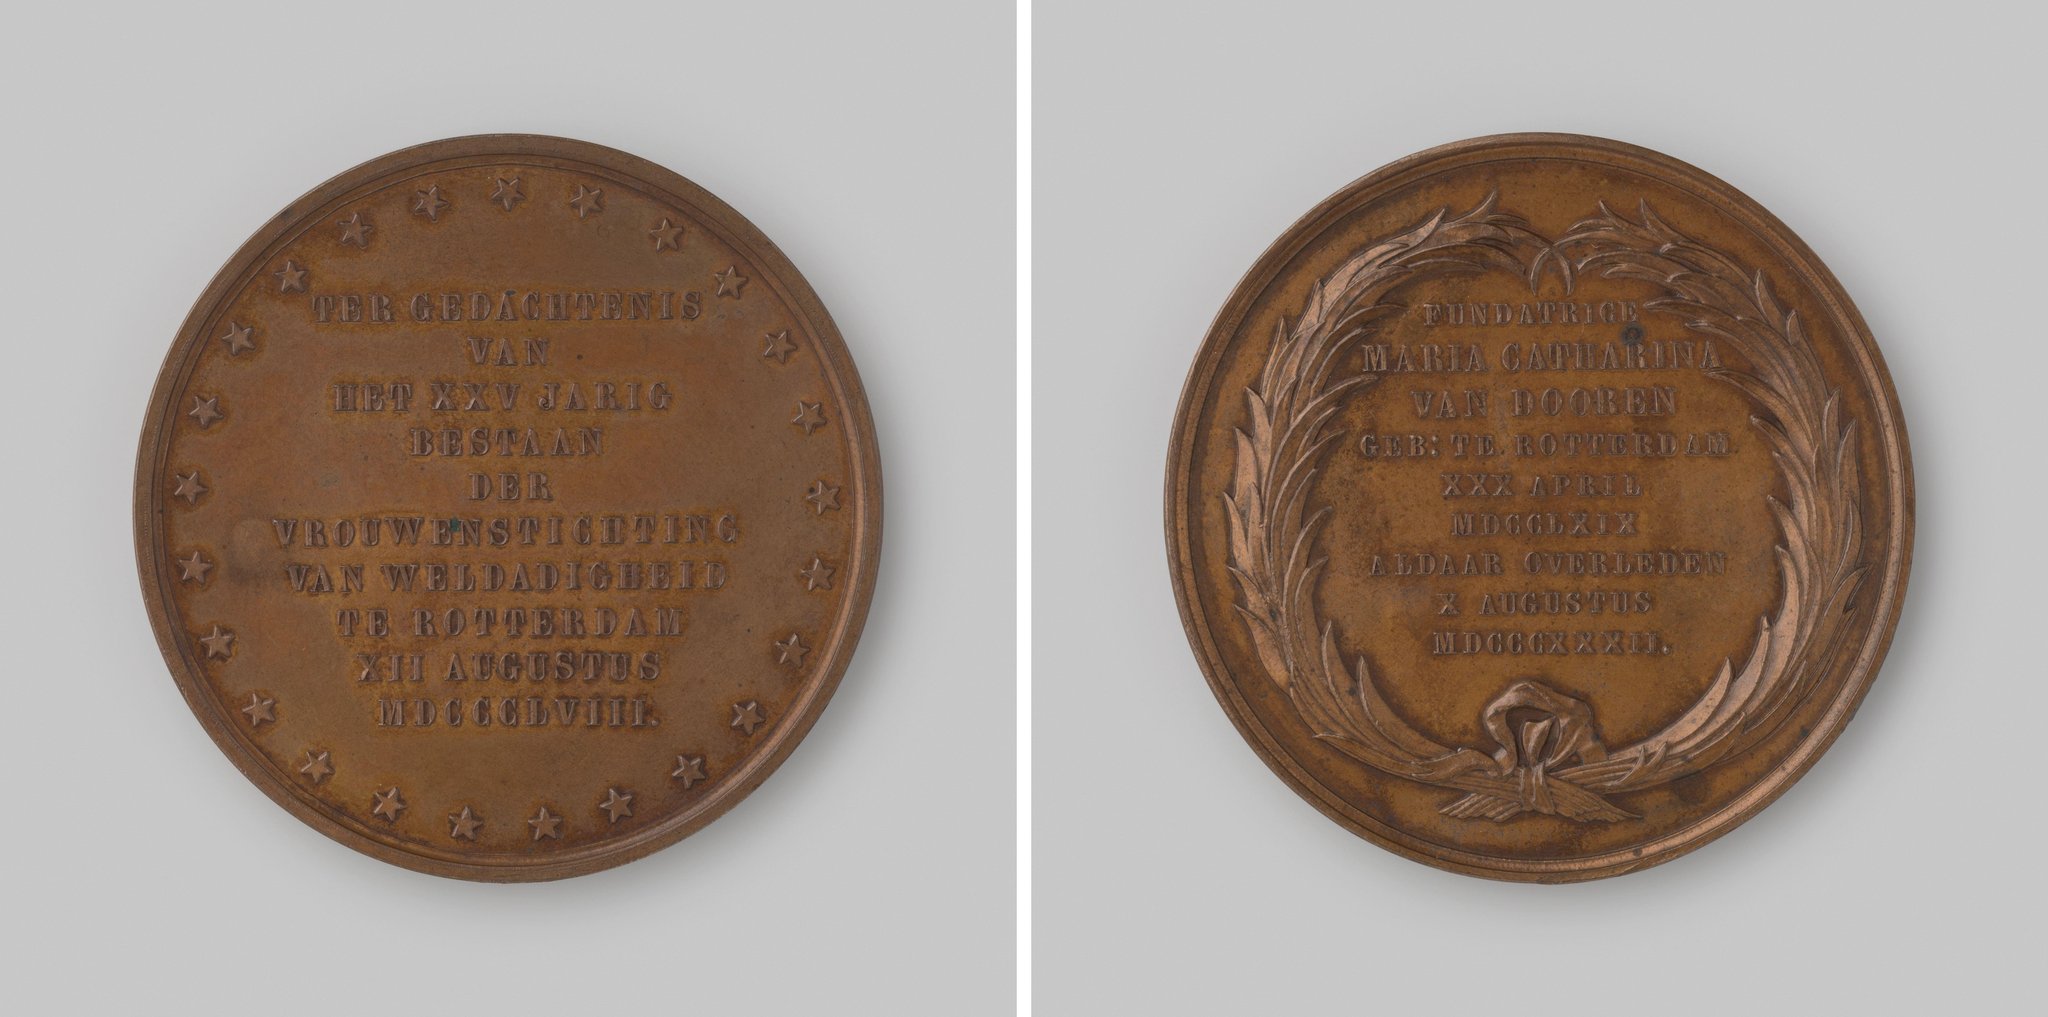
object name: history medal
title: Vijfentwintigjarig bestaan van de vrouwenstichting van weldadigheid te Rotterdam, opgericht door Maria Catharina van Dooren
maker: Anonymous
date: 1858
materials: bronze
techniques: striking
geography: netherlands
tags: rotterdam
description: Bronzen penning. Voorzijde: opschrift binnen krans van vijfentwintig sterren. Keerzijde: opschrift binnen krans van palmtakken